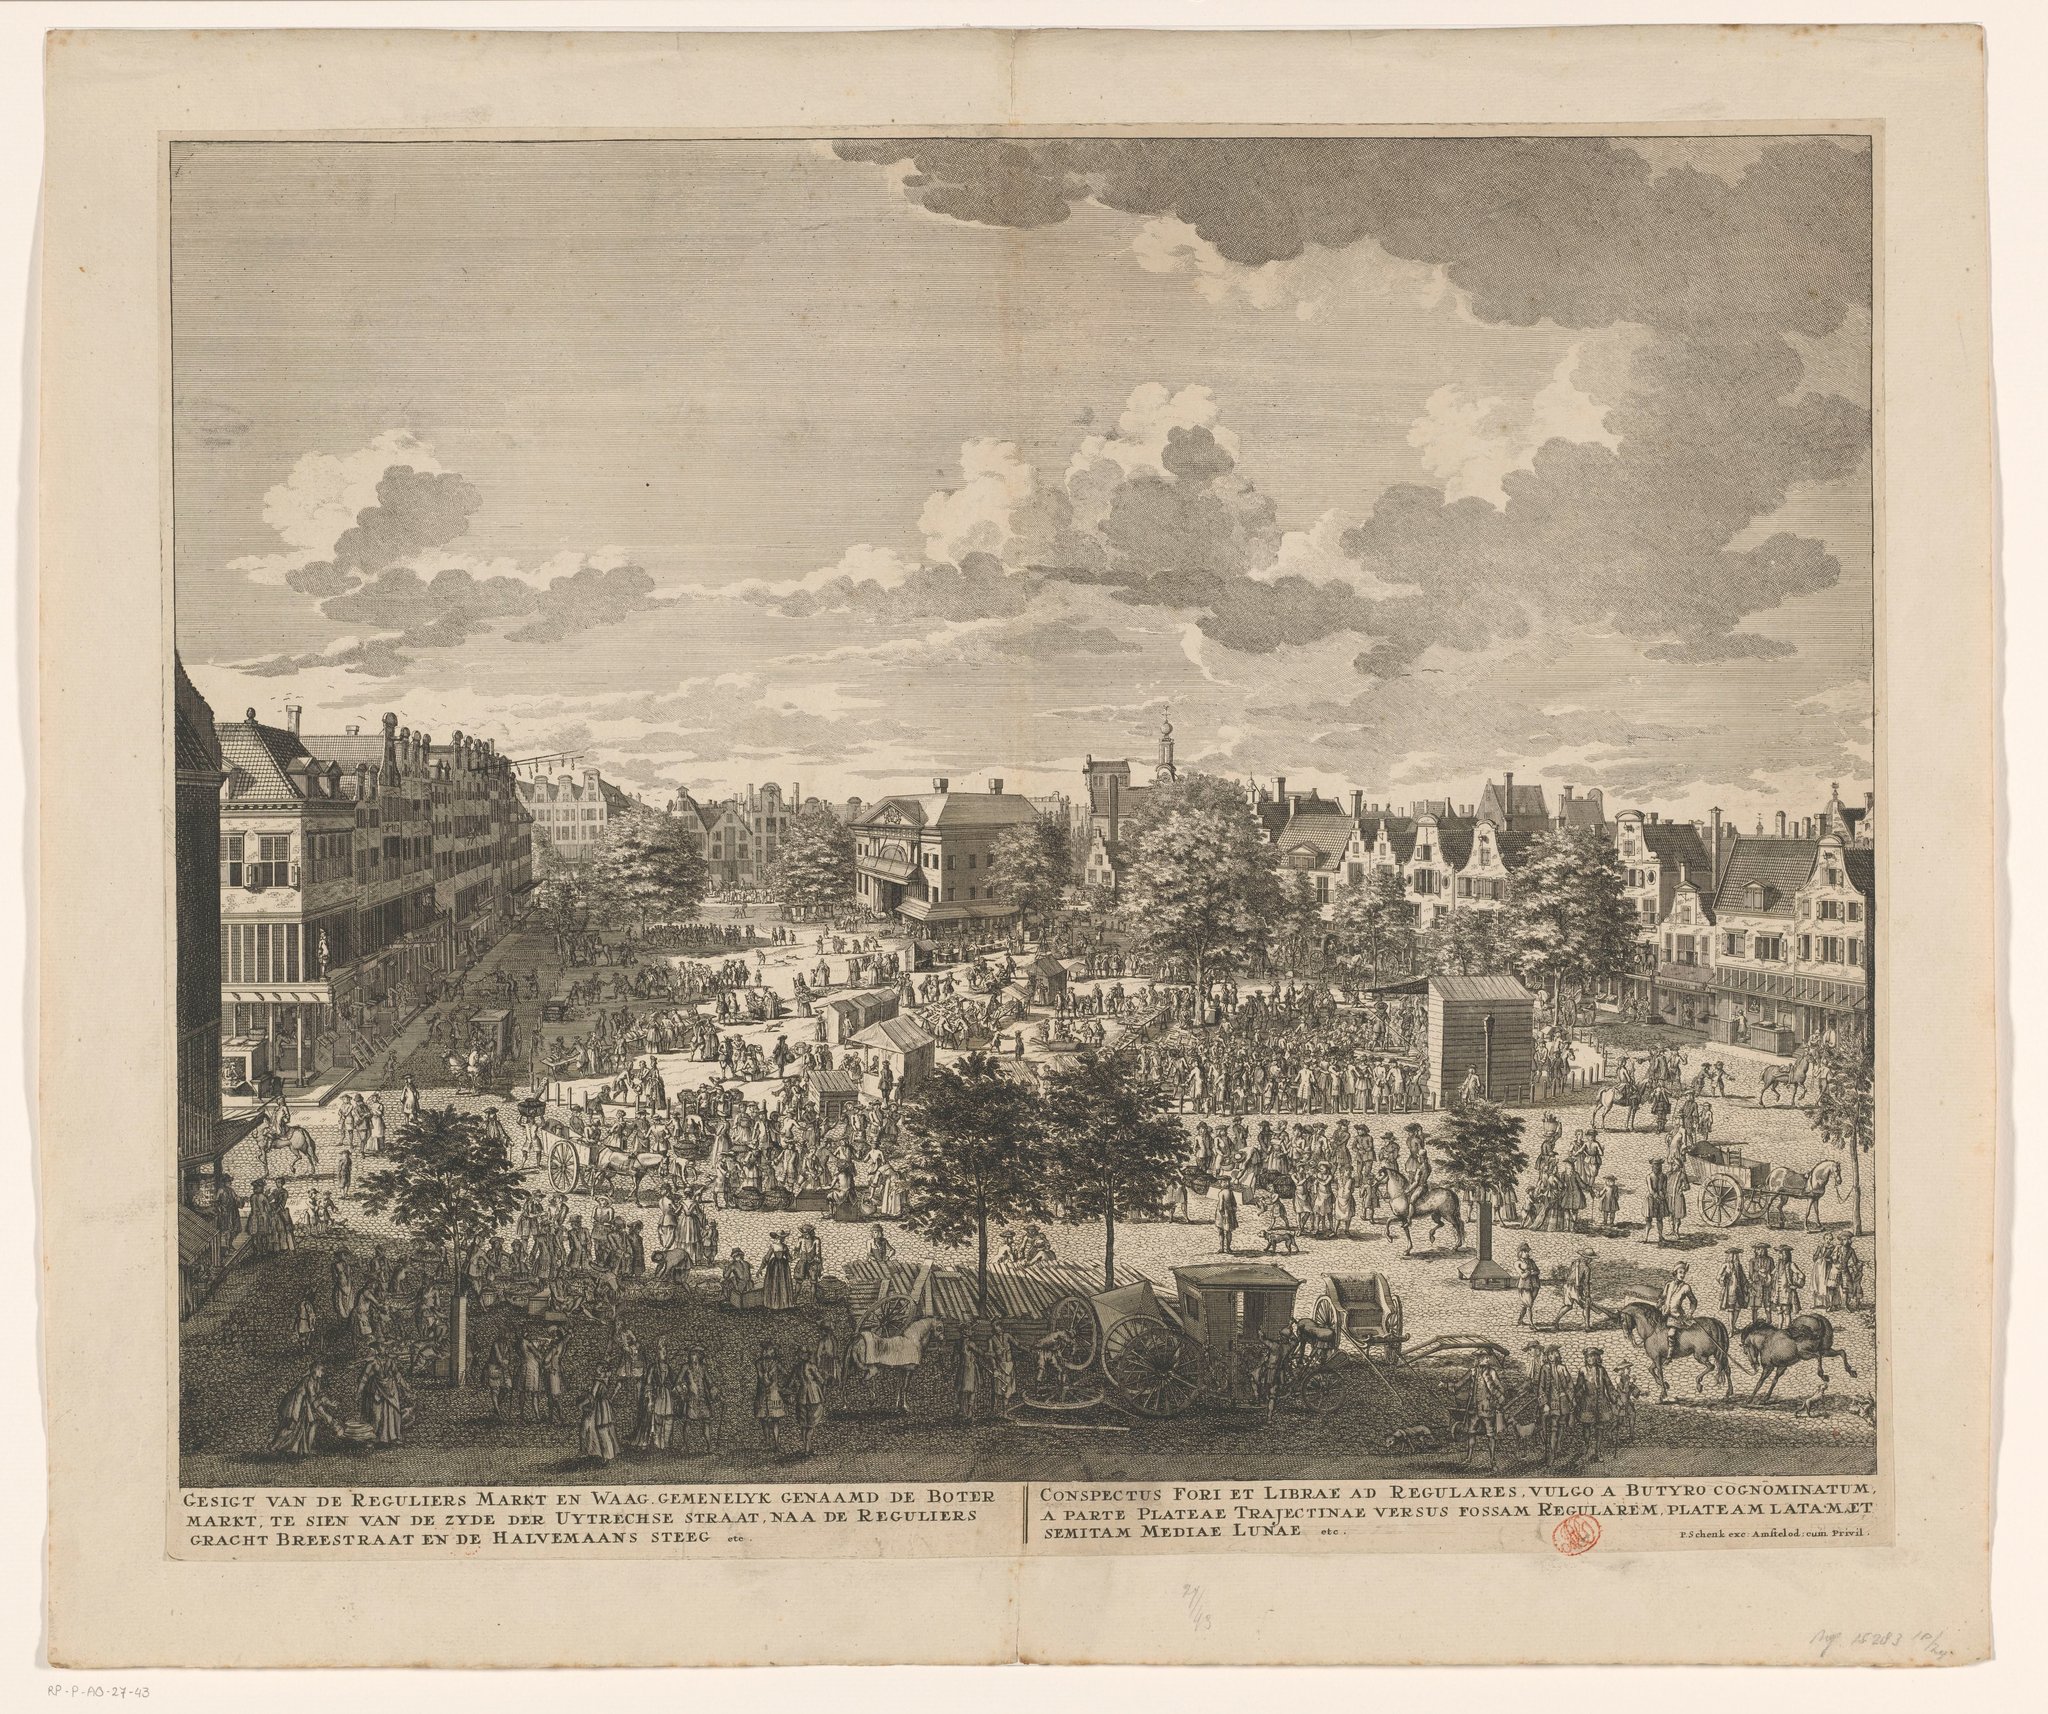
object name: print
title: Gezicht op de Botermarkt (Reguliersmarkt) te Amsterdam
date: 1700-1711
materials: paper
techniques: engraving, etching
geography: amsterdam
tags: buildings for performances - aa - open-air performances, stalls ~ theatre, etc. - aa - open-air performances, stall, booth (~ market), market, weigh-house, square, place, circus, etc. (+ city(-scape) with figures, staffage)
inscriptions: collector's mark: Lugt 195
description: Gezicht op de Botermarkt, ook bekend als de Reguliersmarkt (het huidige Rembrandtplein), te Amsterdam. Gezien richting het westen, met links de ingang van de Utrechtsestraat. In het midden op de achtergrond de Boterwaag, ook bekend als de Regulierswaag, in de voormalige Derde Regulierspoort. Op het plein vele figuren en veel bedrijvigheid. Marktlui bieden allerlei koopwaar aan. Rechts van het midden wordt op een podium in open lucht een voorstelling gegeven. Onder de voorstelling de titel in het Nederlands en Latijn.